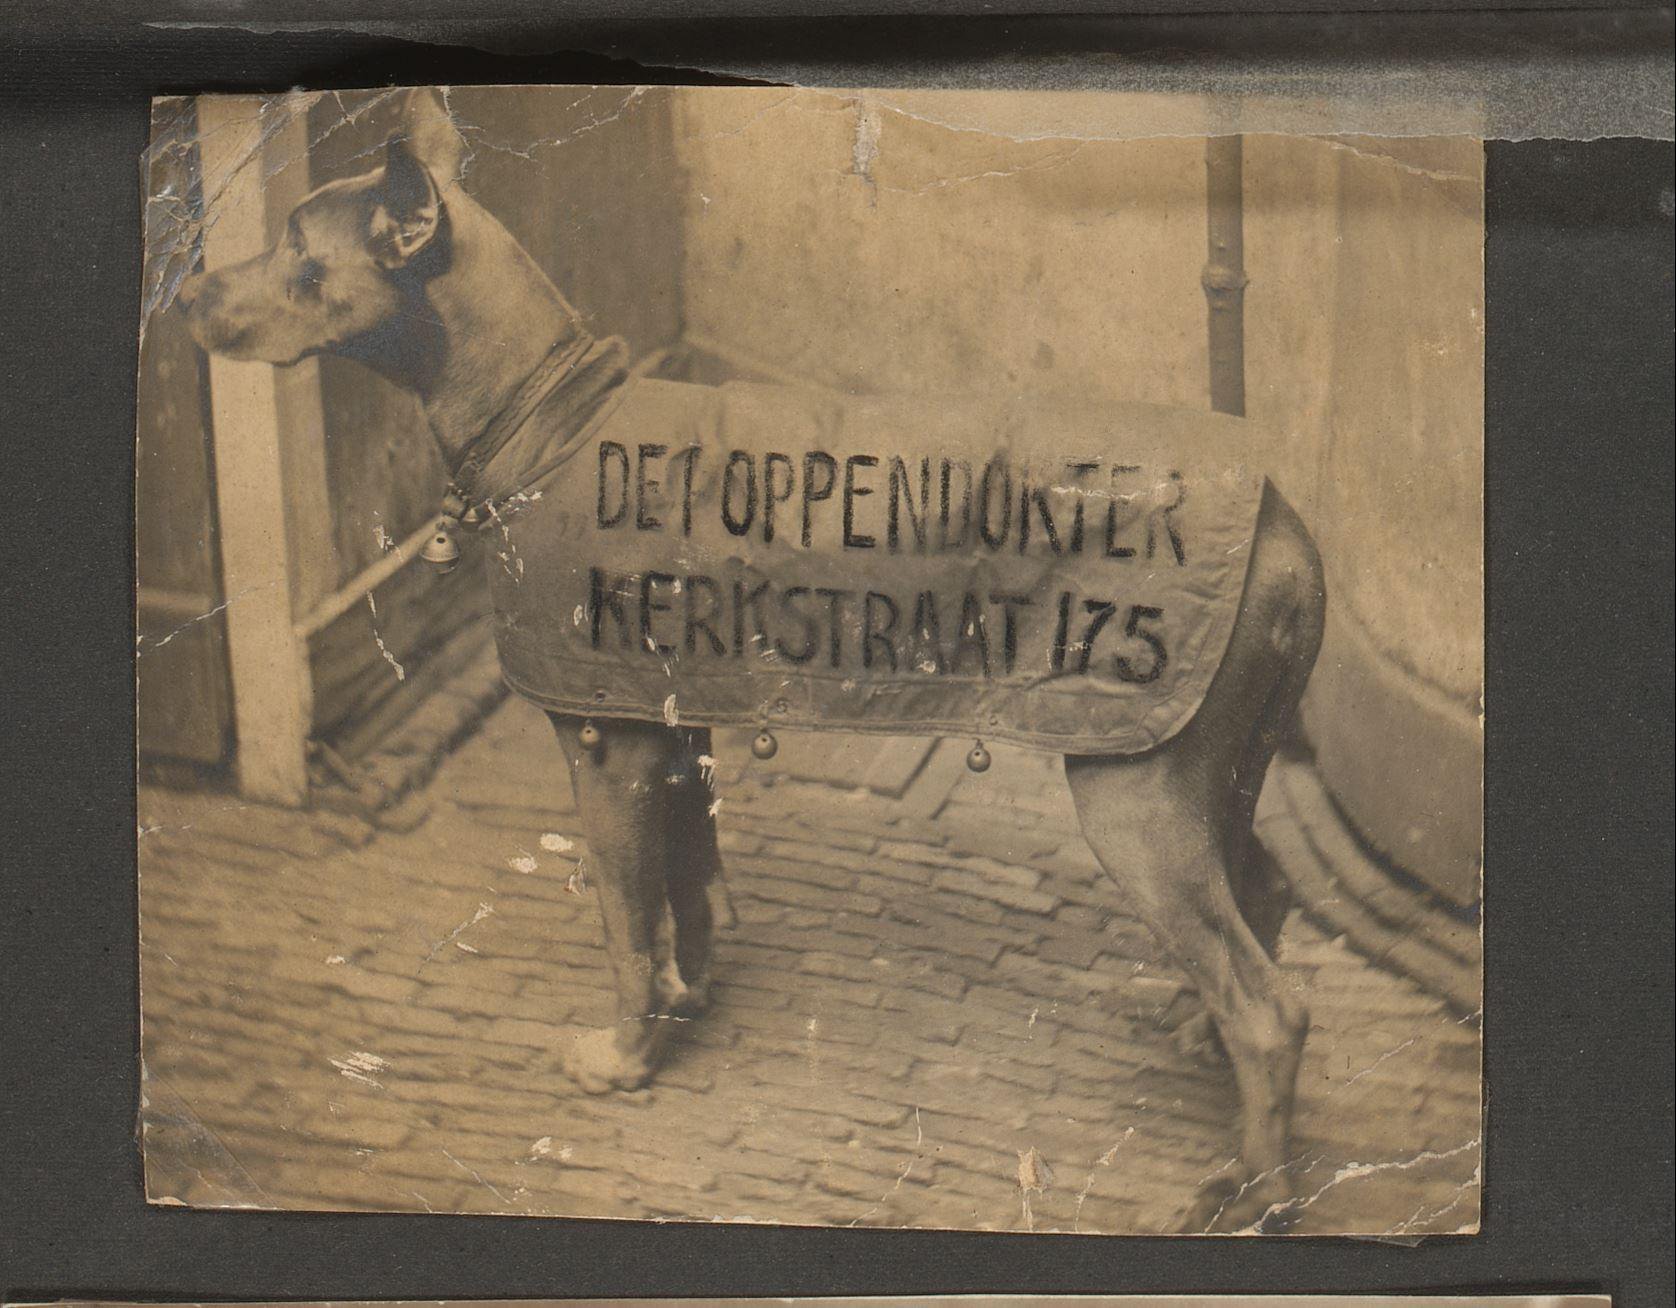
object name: photograph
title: Hond met reclametekst van De Poppendokter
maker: Anonymous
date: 1930-1940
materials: photographic support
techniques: gelatin silver print, writing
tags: advertising, dog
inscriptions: annotation: ‘De Poppendokter’